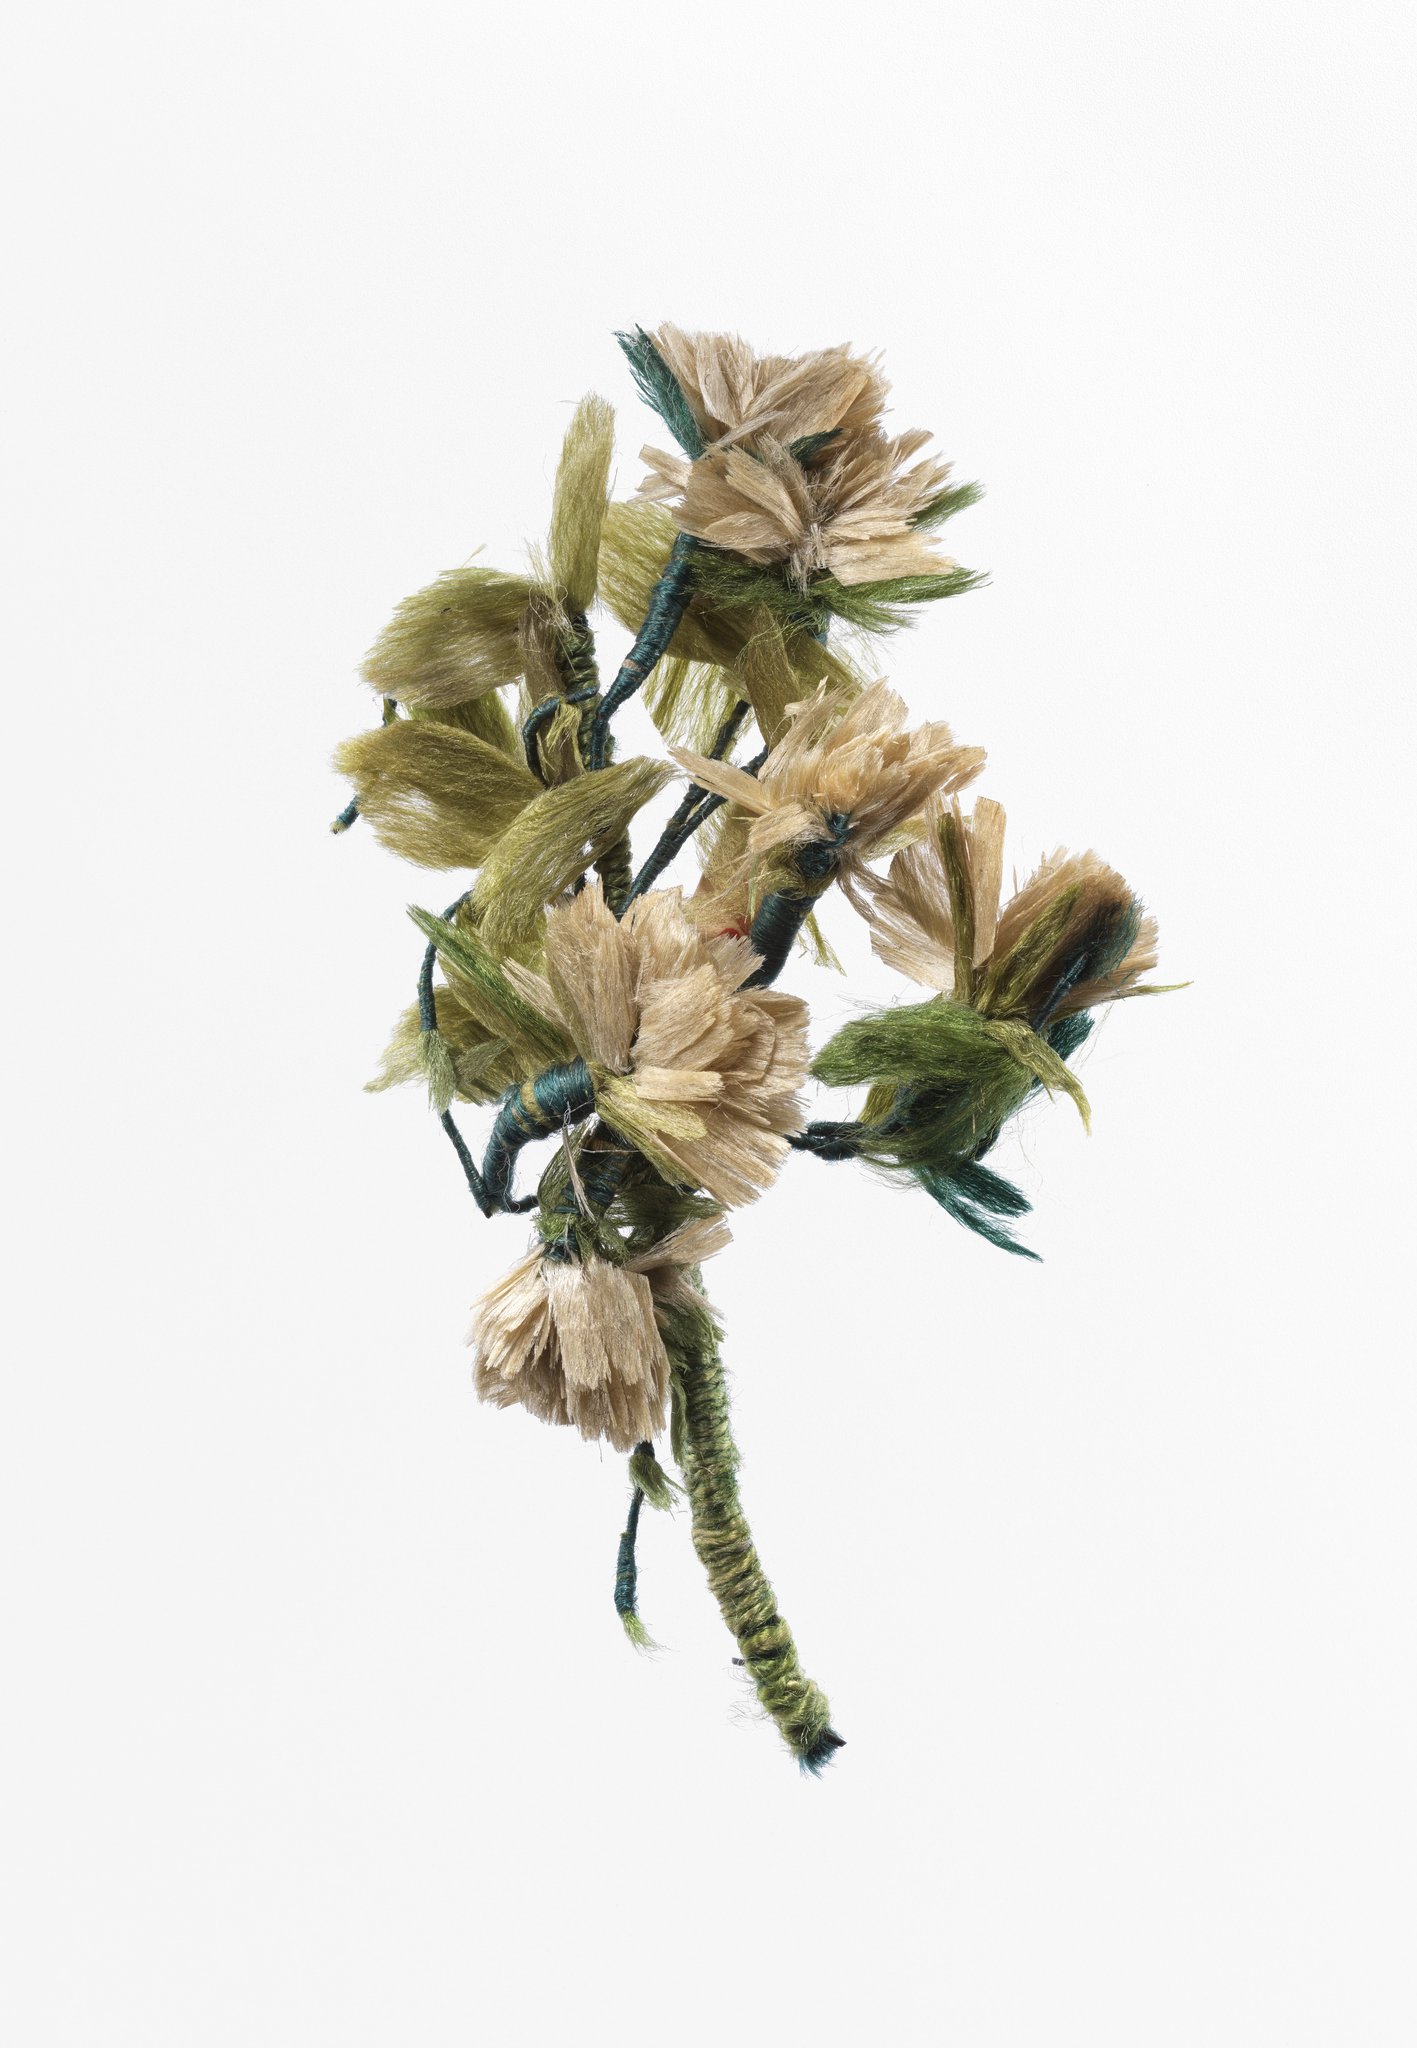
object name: boutonnière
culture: british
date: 1625-1649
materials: silk